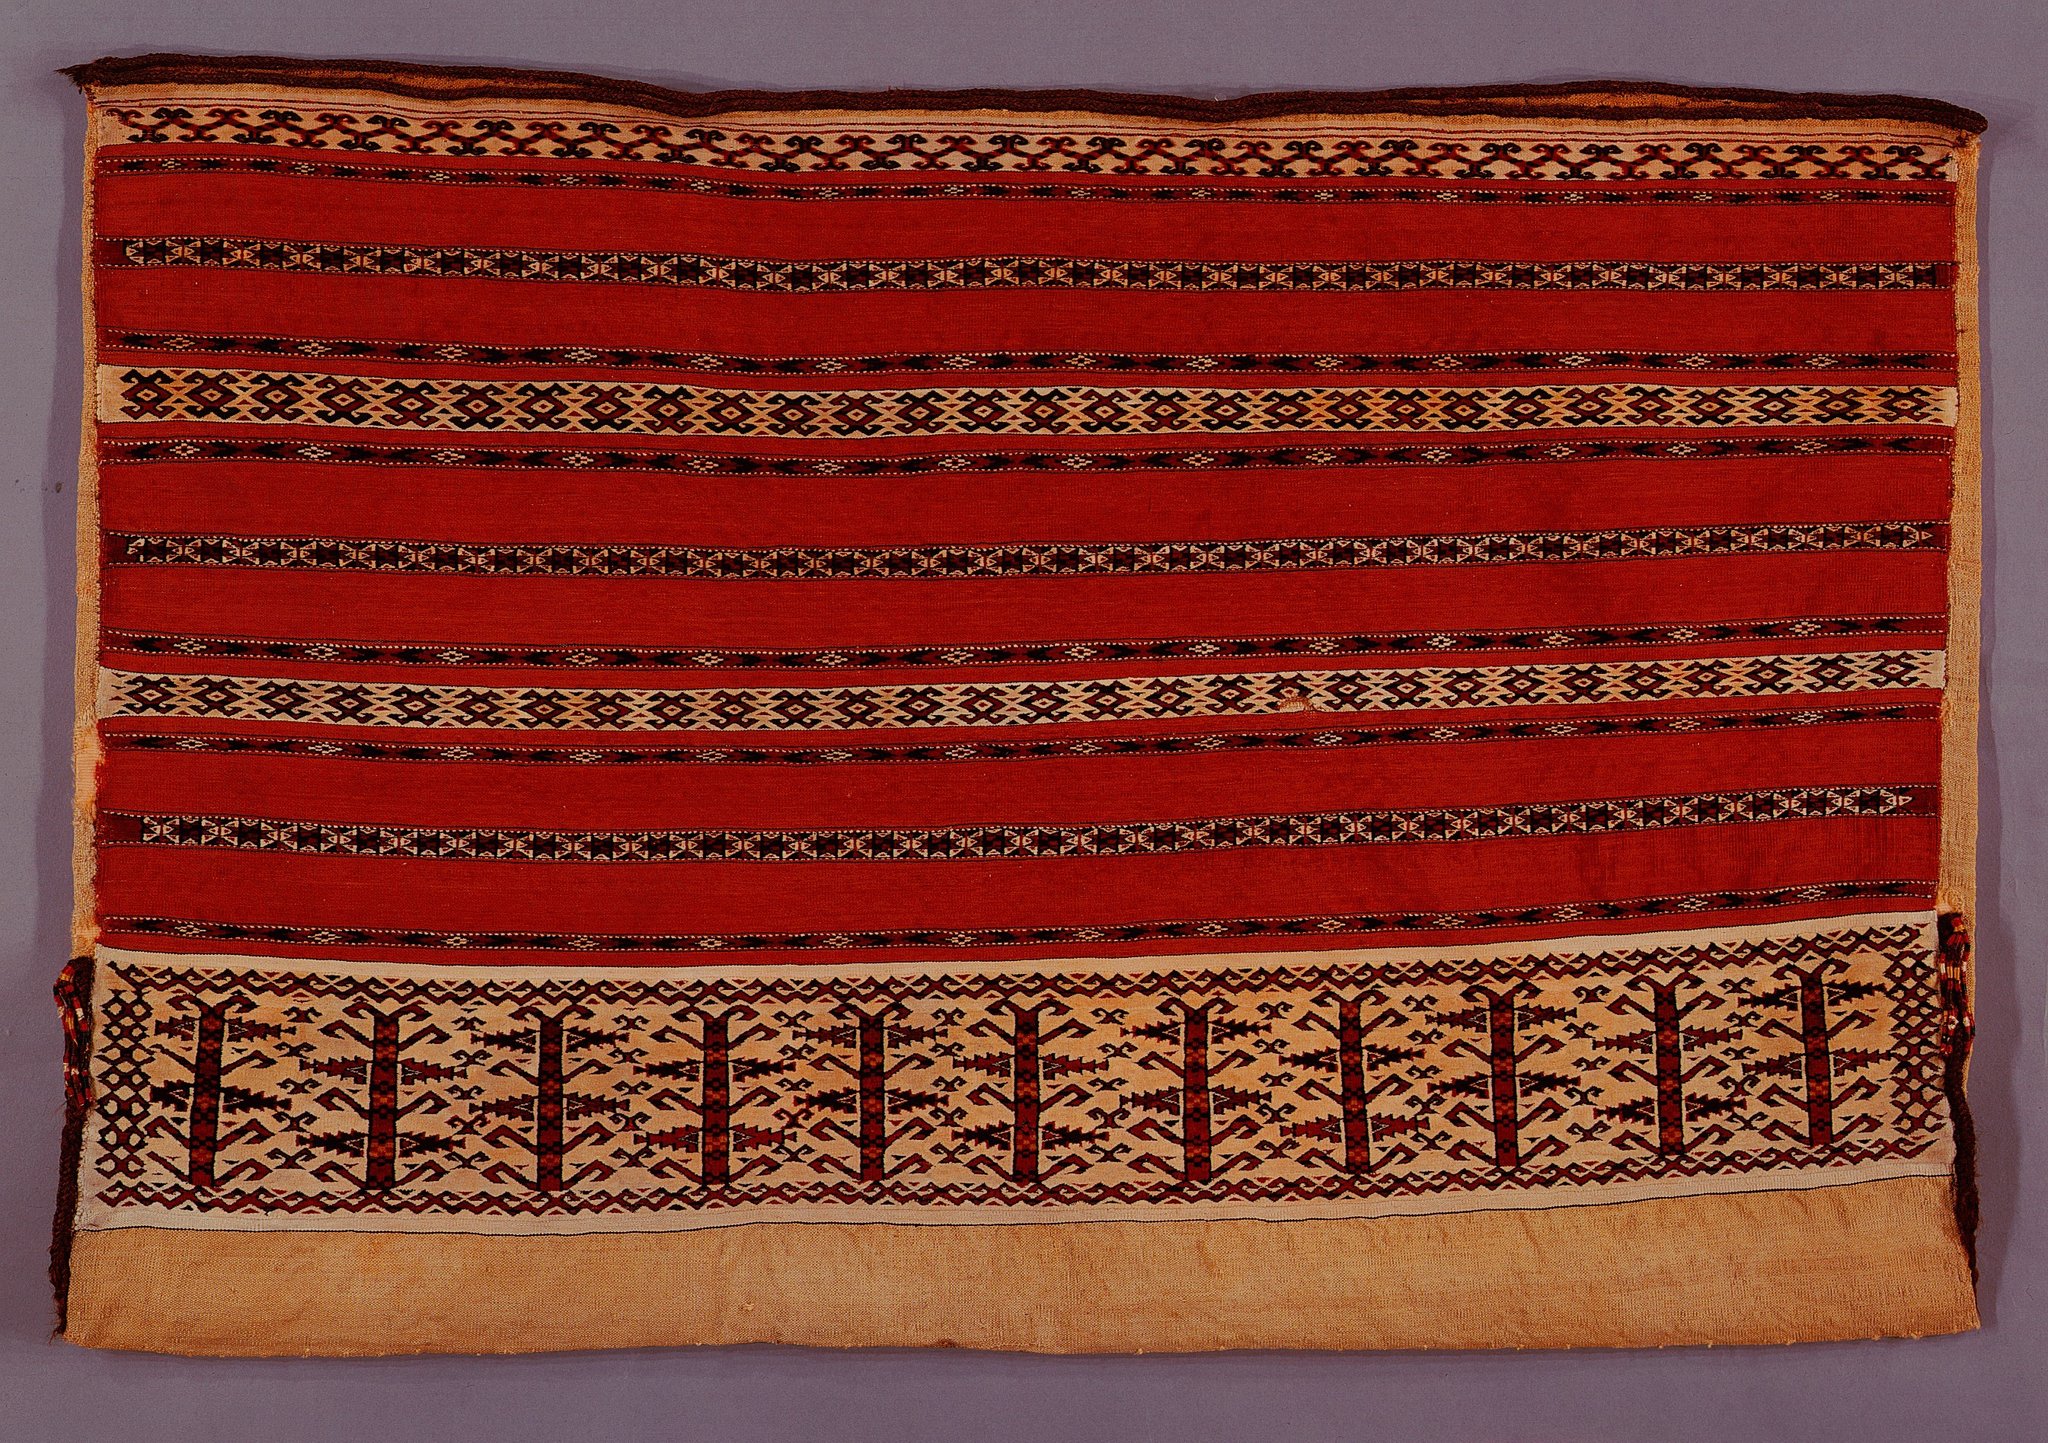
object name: storage bag fragment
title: Fragment of a Storage Bag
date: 1801-1850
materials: cotton, silk, wool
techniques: asymmetrically knotted pile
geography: turkmenistan